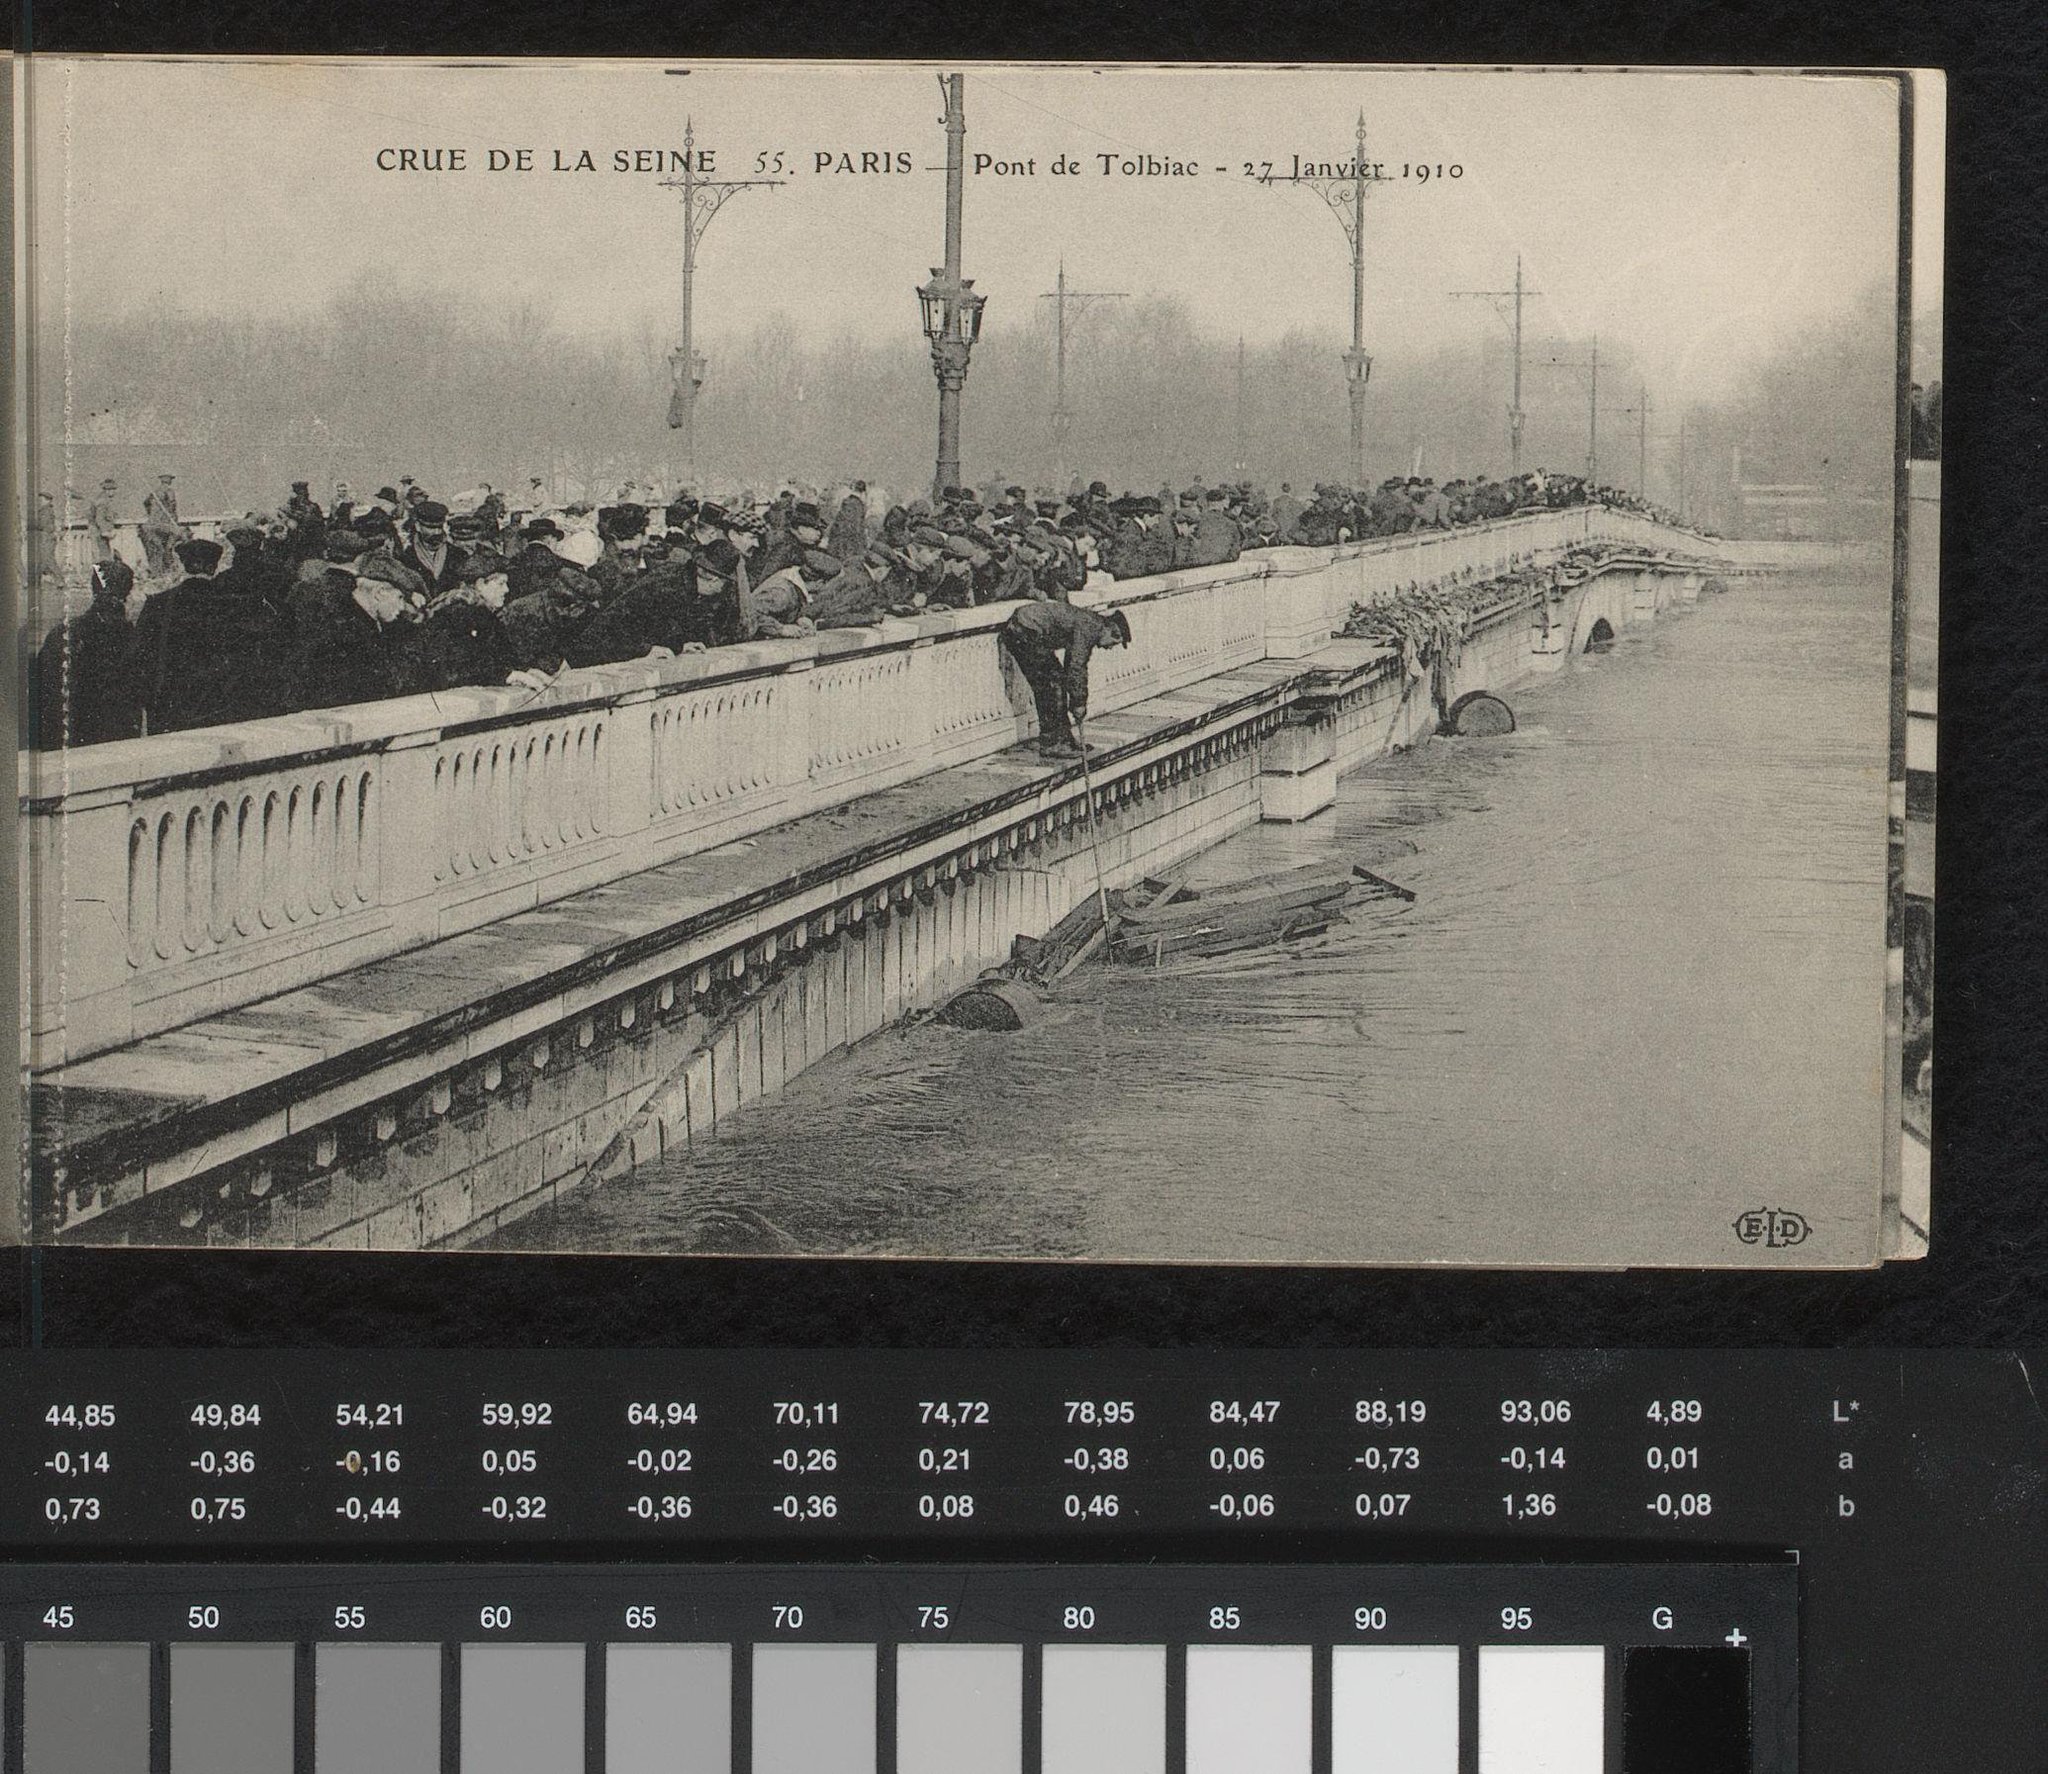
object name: ansichtkaart, prentbriefkaart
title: Paris. Pont de Tolbiac. 27 Janvier 1910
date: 1910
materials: cardboard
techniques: photograph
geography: paris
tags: flood, bridge, city-view, and landscape with man-made constructions (+ city(-scape) with figures, staffage), paris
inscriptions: date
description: Prentbriefkaart maakt deel uit van een album.